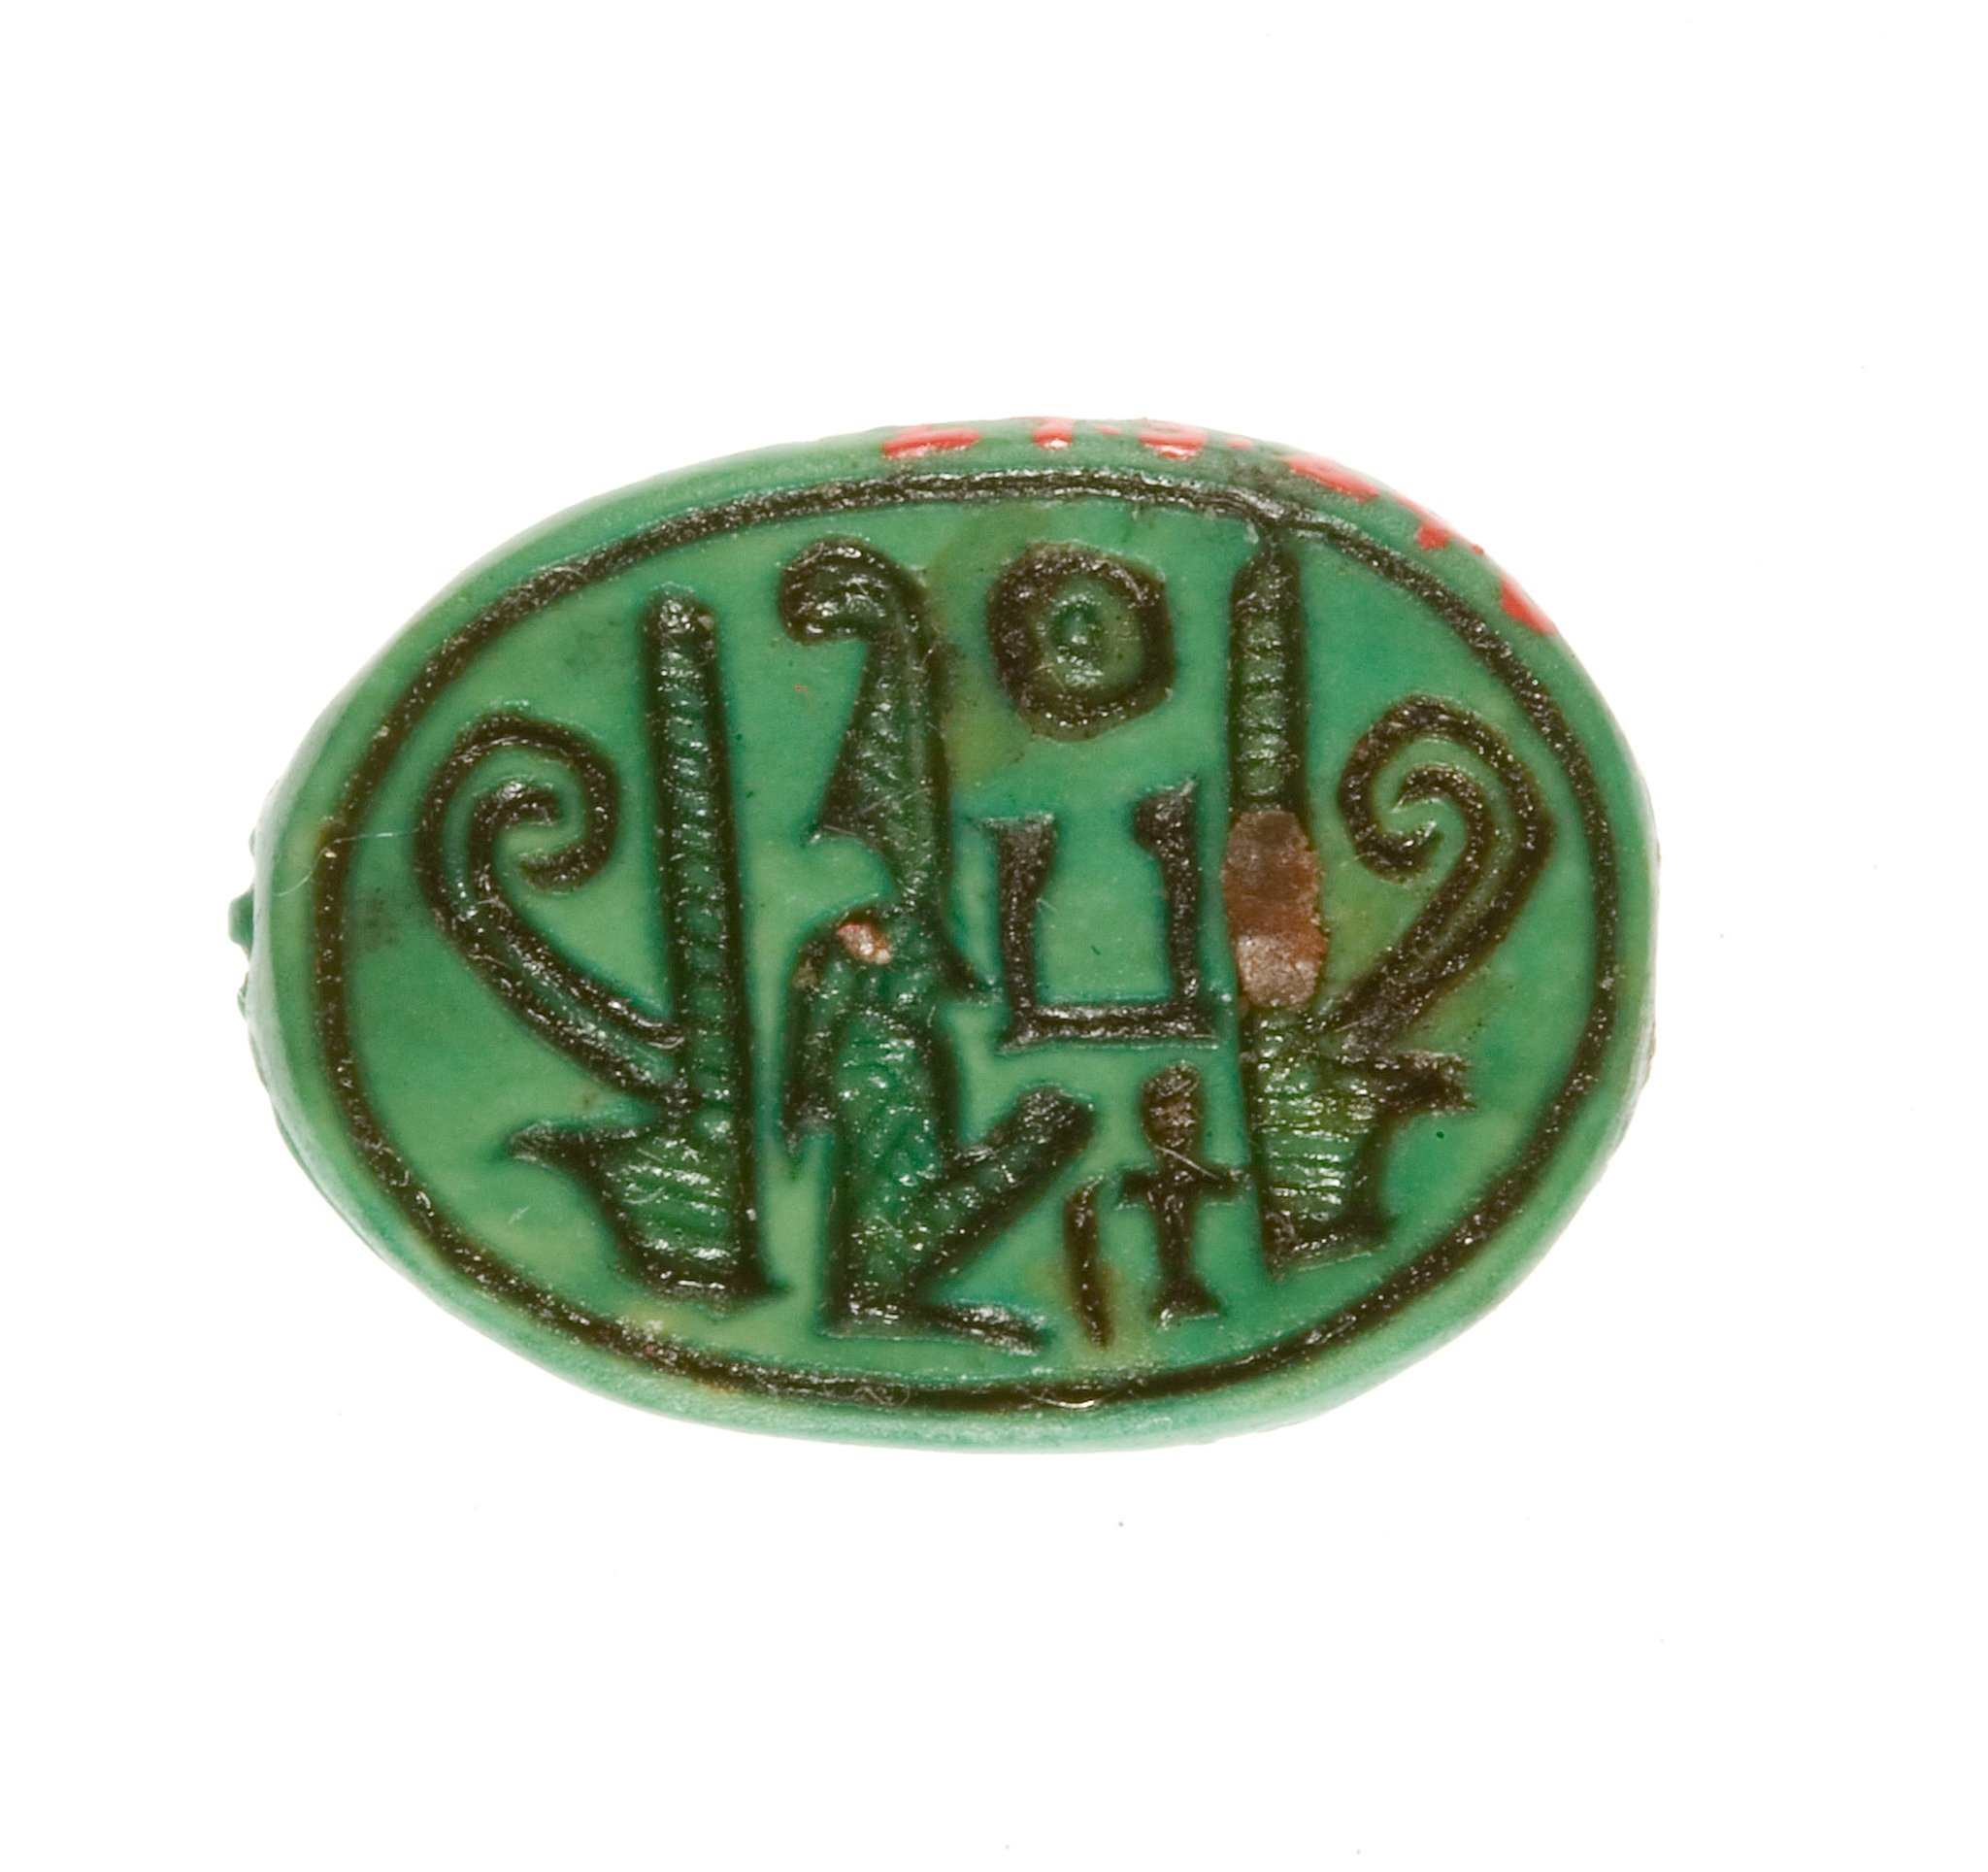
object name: scarab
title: Scarab Inscribed for the Perfect God Maatkare (Hatshepsut), Flanked by Two Red Crowns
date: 1479-1458 BCE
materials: stone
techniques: glazing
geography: egypt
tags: scarabs